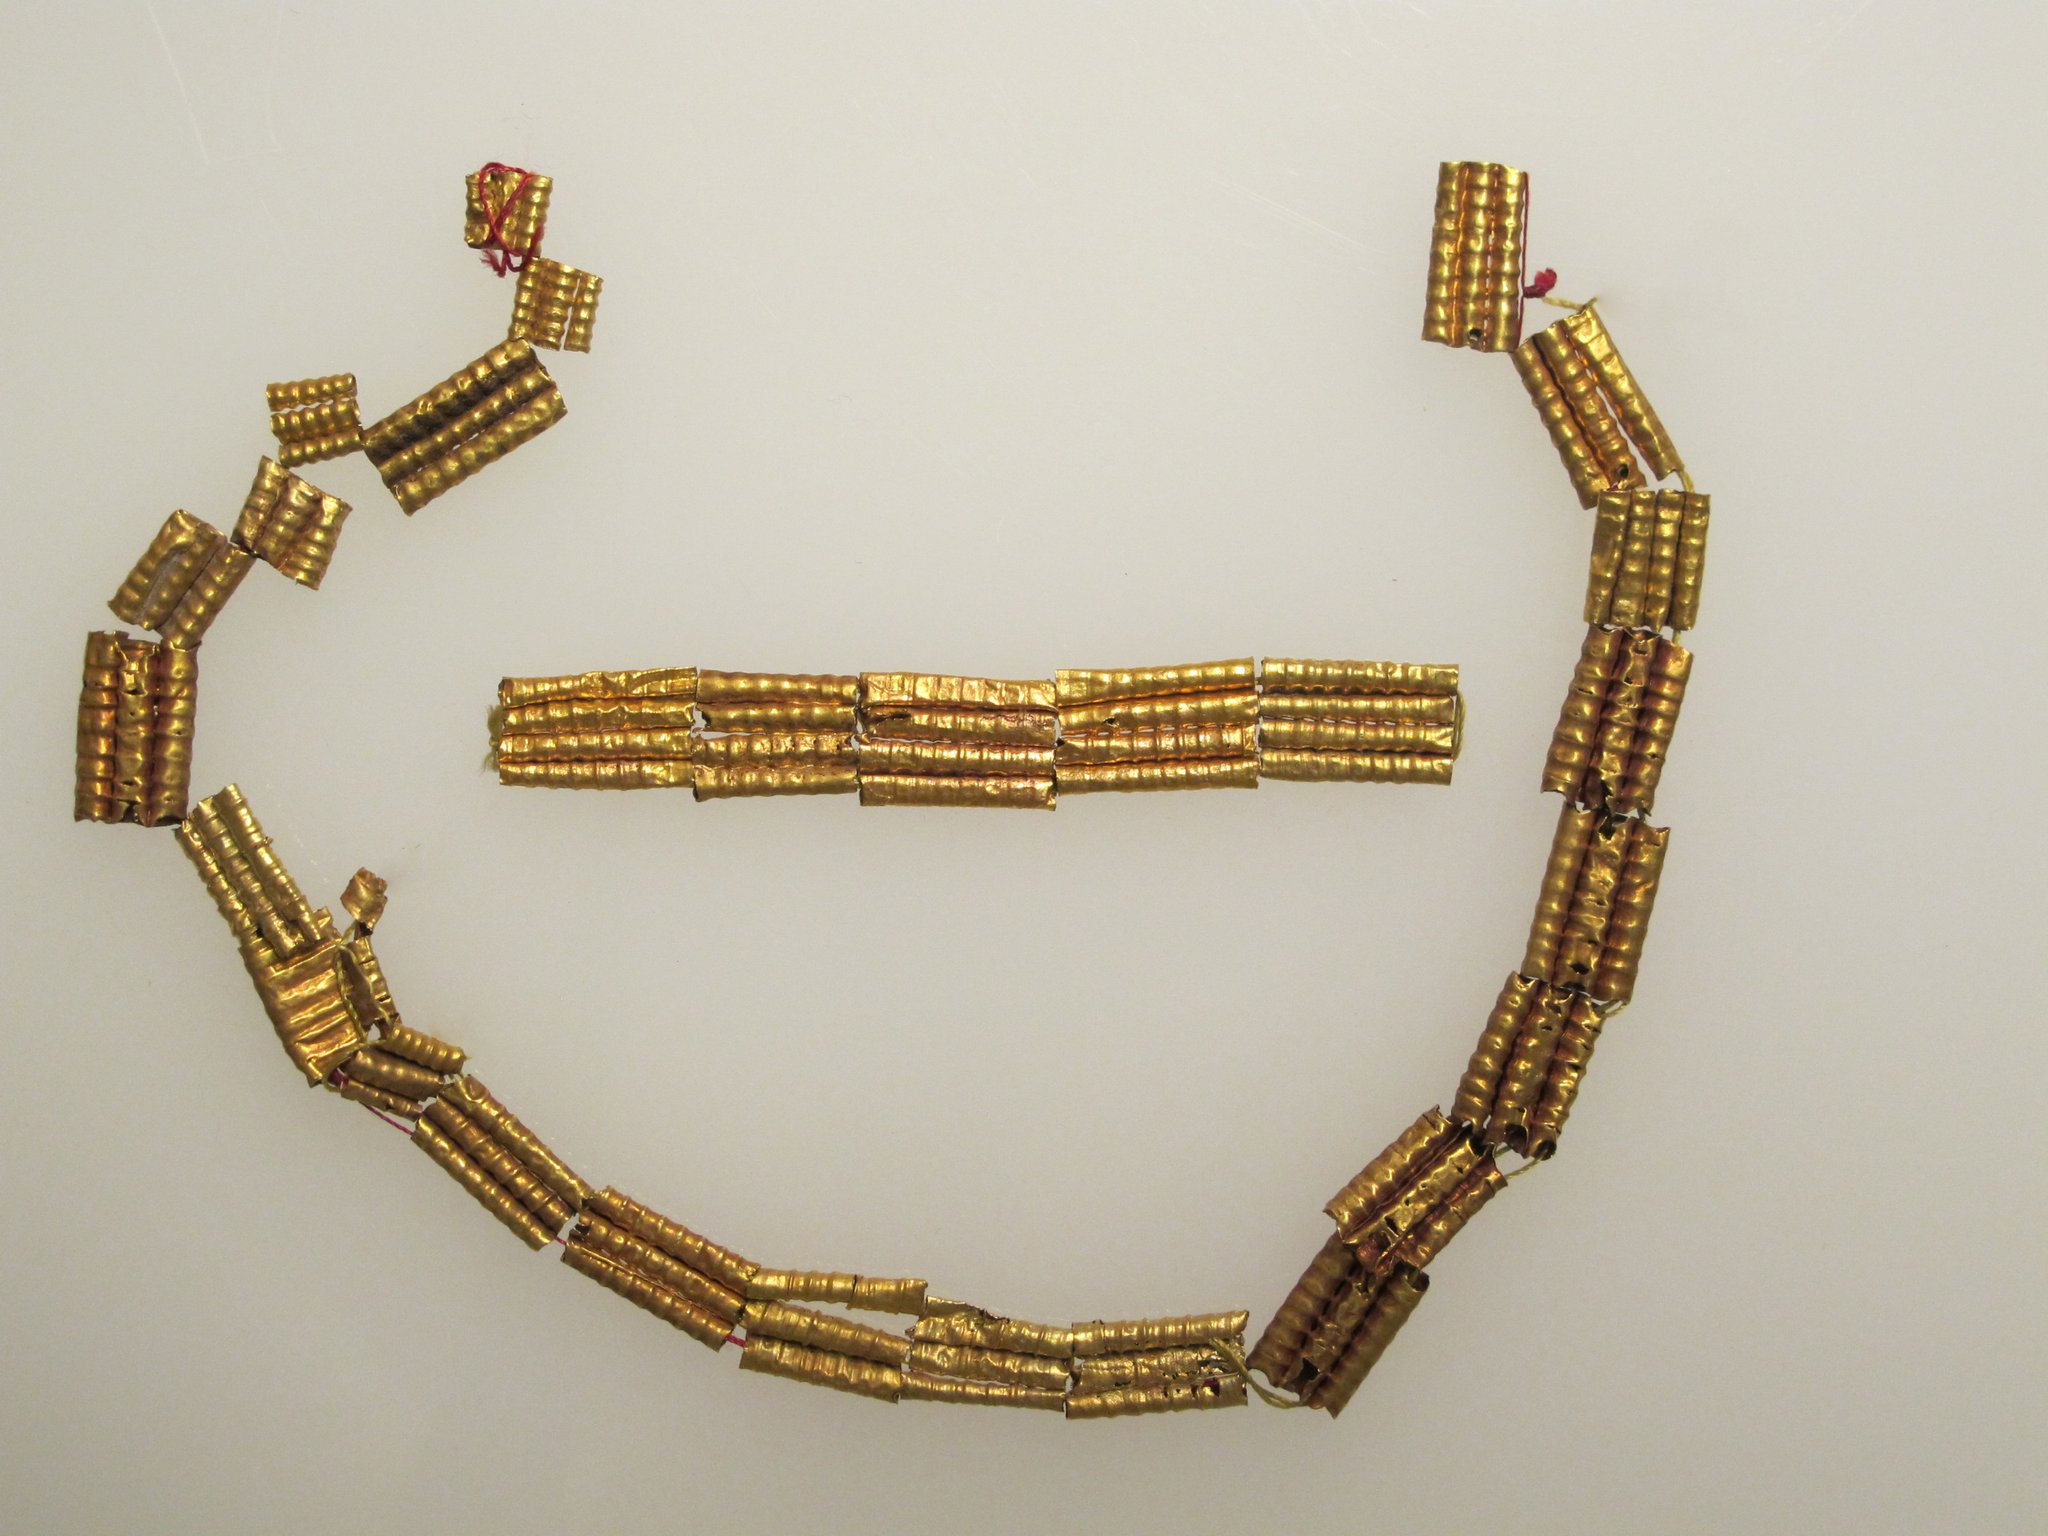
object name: necklace, fragmentary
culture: roman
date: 201-300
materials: gold